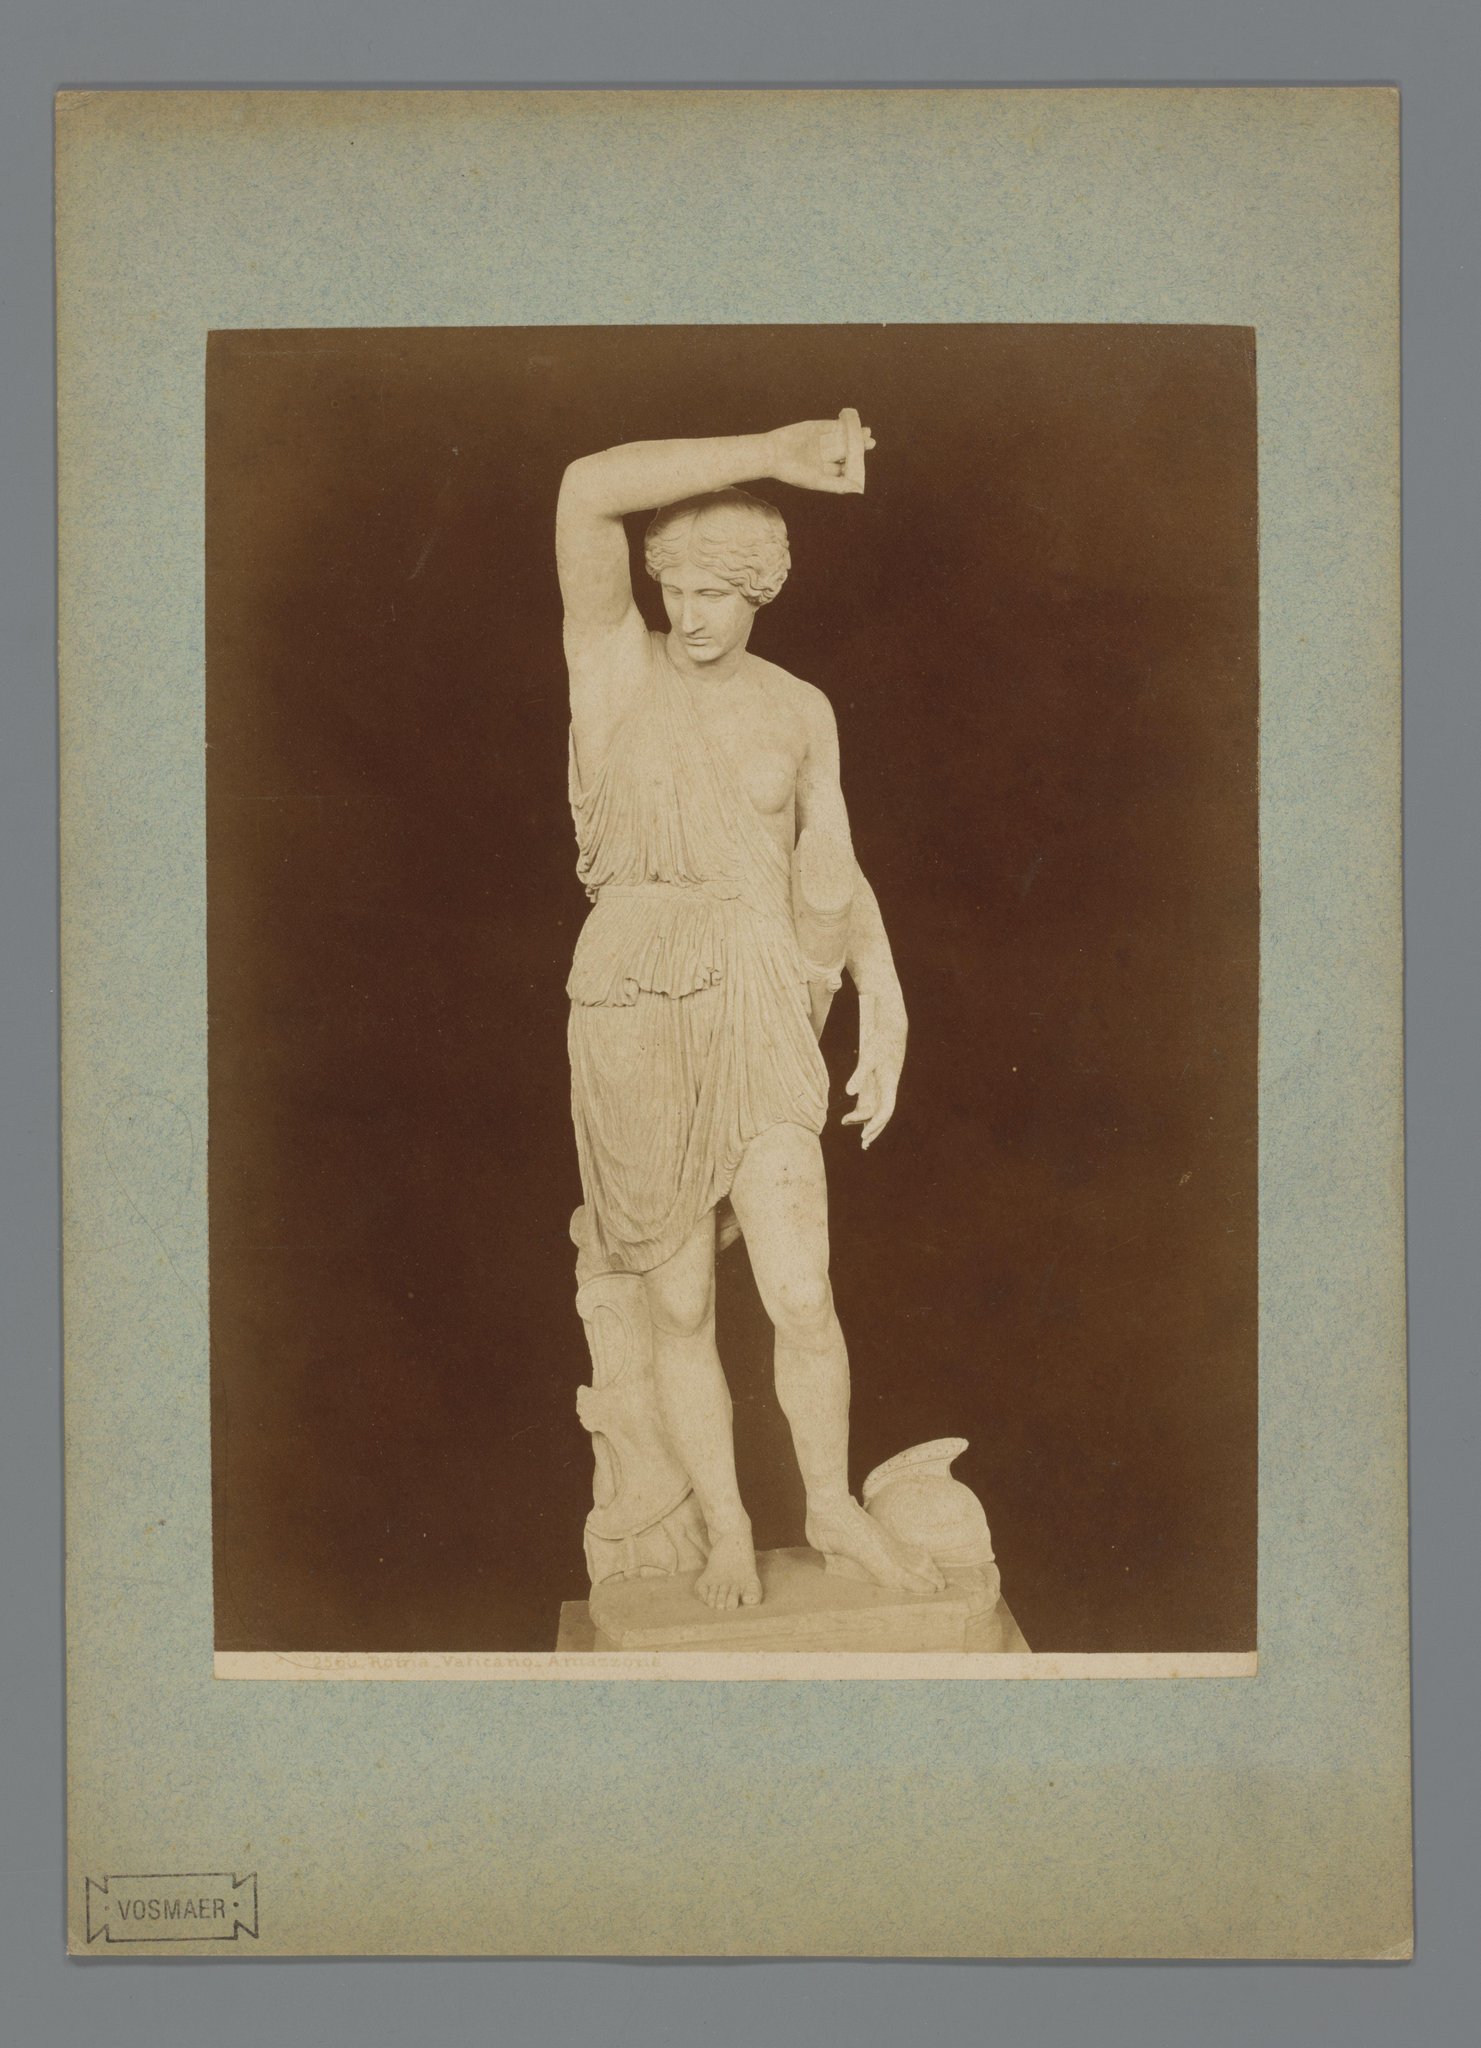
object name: photograph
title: Vaticano Amazzone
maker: Anonymous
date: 1851-1890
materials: cardboard, paper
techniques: albumen print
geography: vatican city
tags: (story of) the amazons, sculpture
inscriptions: number: ‘2560’, inscription: ‘doubl’, collector's mark: ‘VOSMAER’